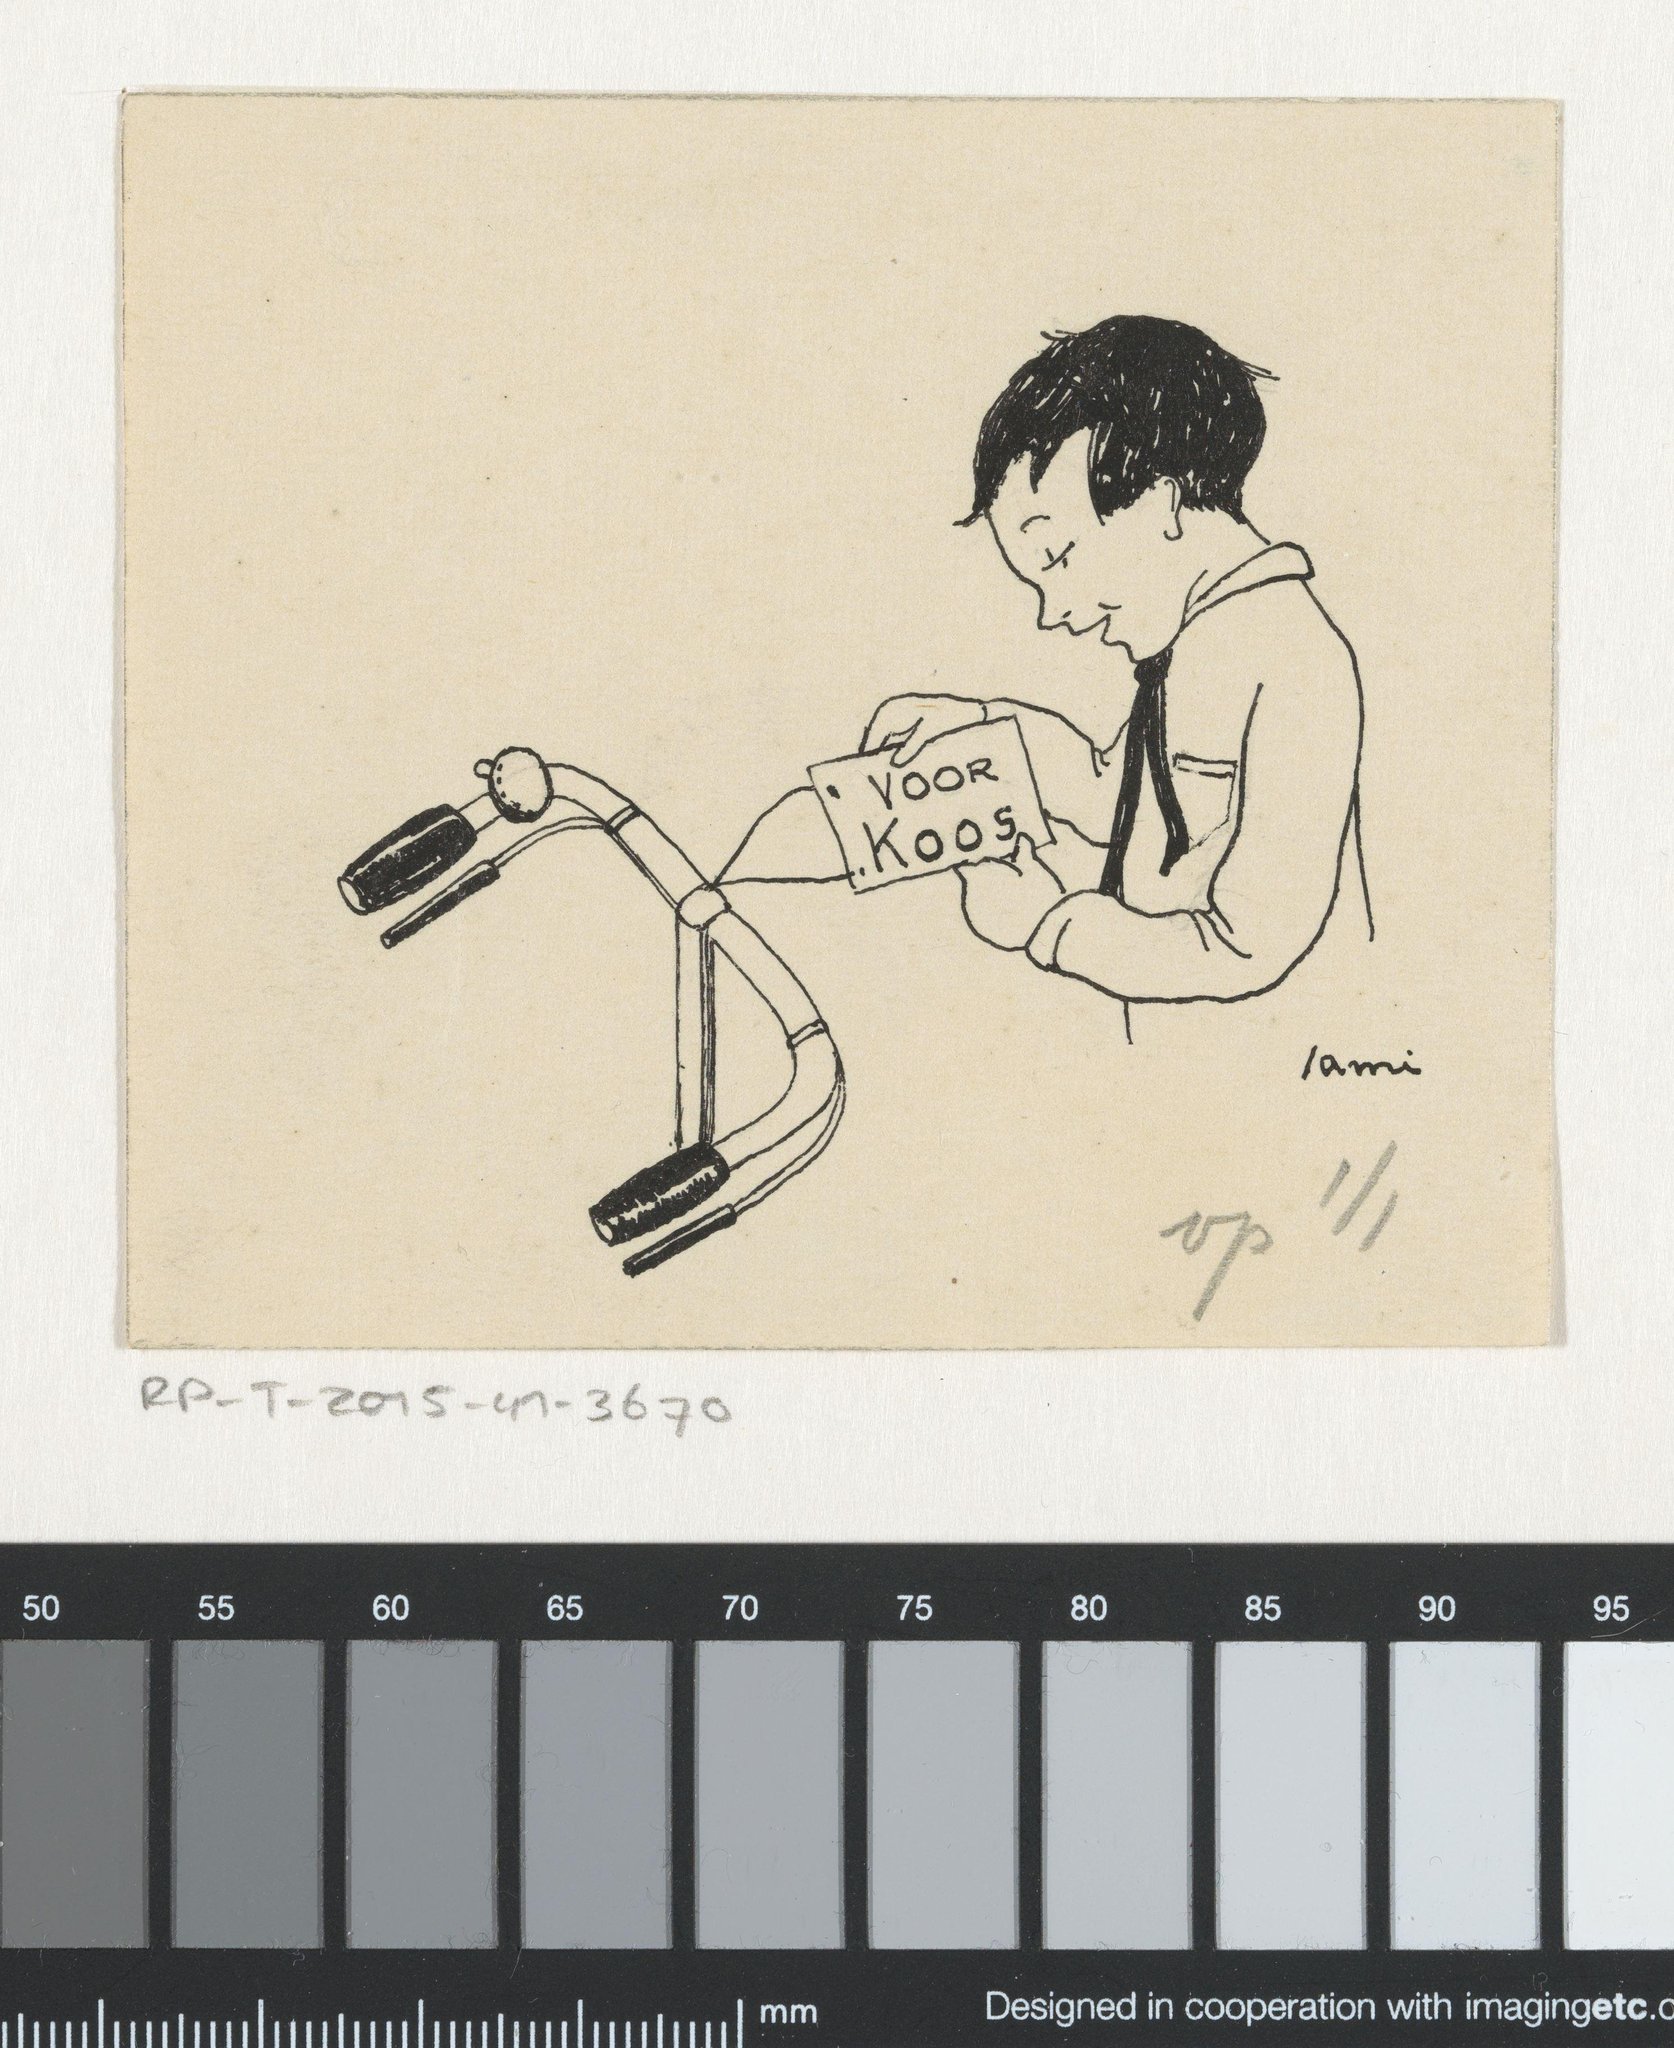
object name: drawing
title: Jongen bekijkt een brief aan een fietsstuur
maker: Anonymous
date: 1880-1930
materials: ink, paper, pencil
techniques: pen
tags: bicycle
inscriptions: annotation: ‘Sept. 3’, collector's mark: Lugt 2228a, signature: ‘lami’, :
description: Op de brief aan het stuur staat 'voor Koos'.